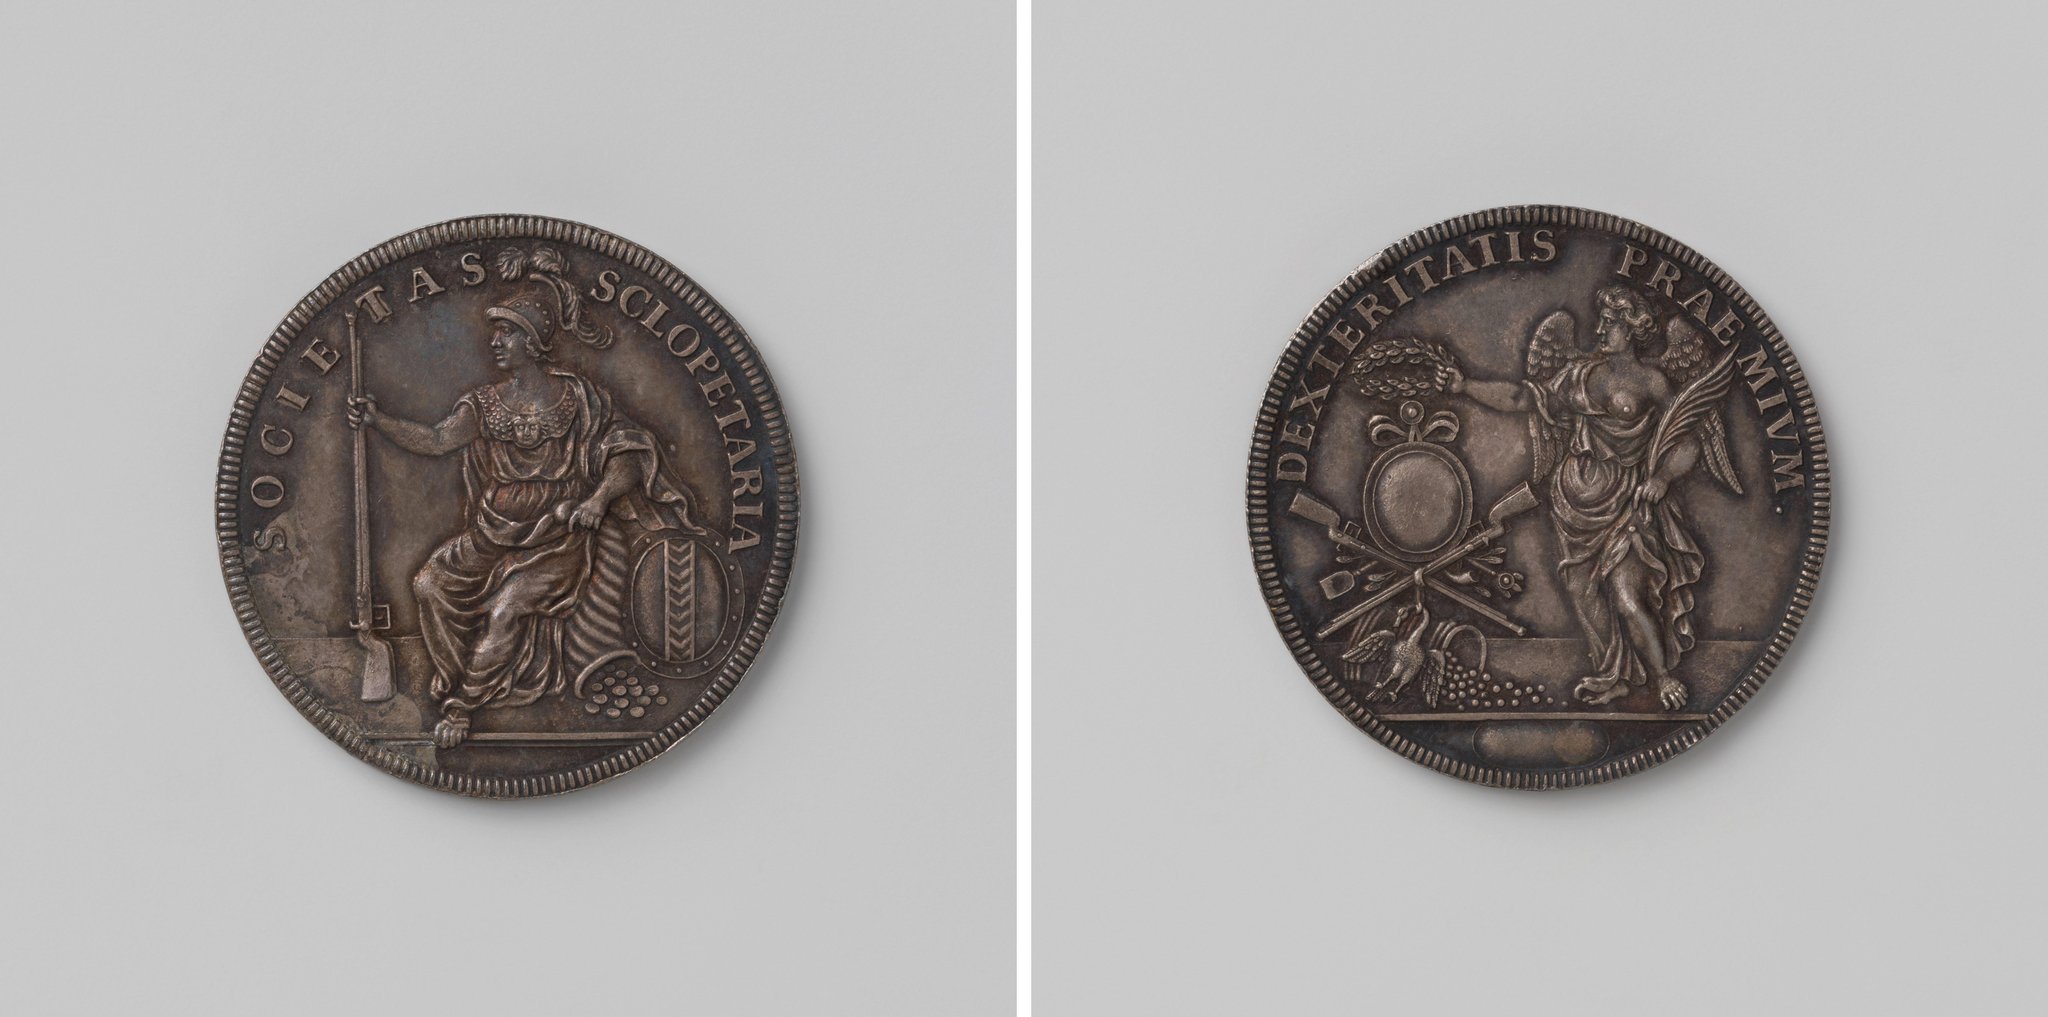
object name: marksman medal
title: Ridderlijke Confrerie van de Handbussche te Delft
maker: gerard van loon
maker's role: designer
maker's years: 1683-1758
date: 1718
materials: silver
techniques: striking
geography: netherlands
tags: delft